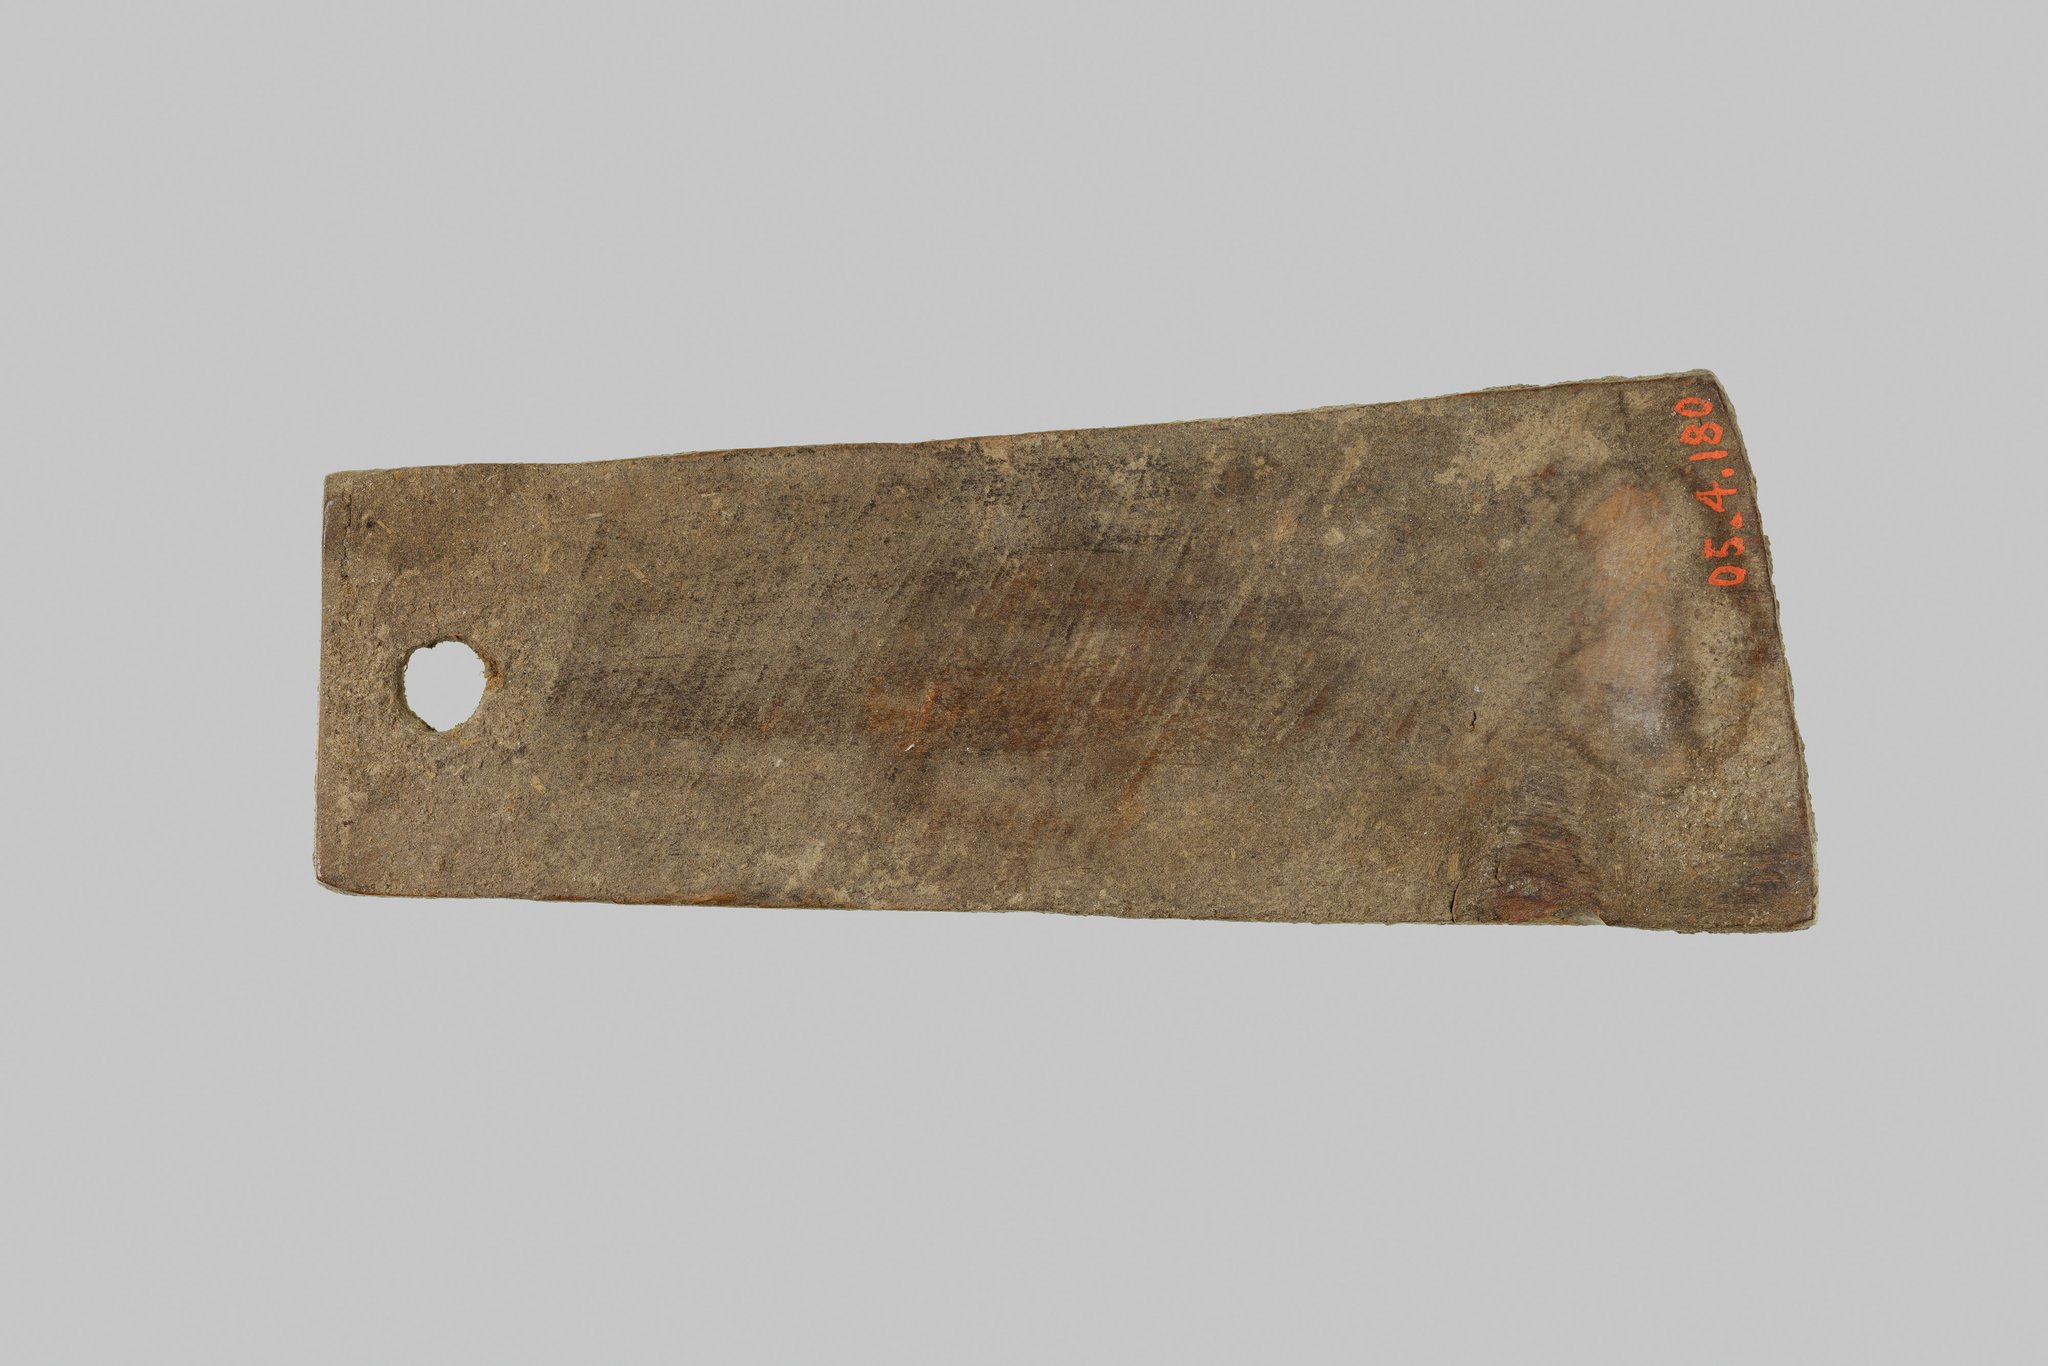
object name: mummy label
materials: ink, wood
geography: egypt